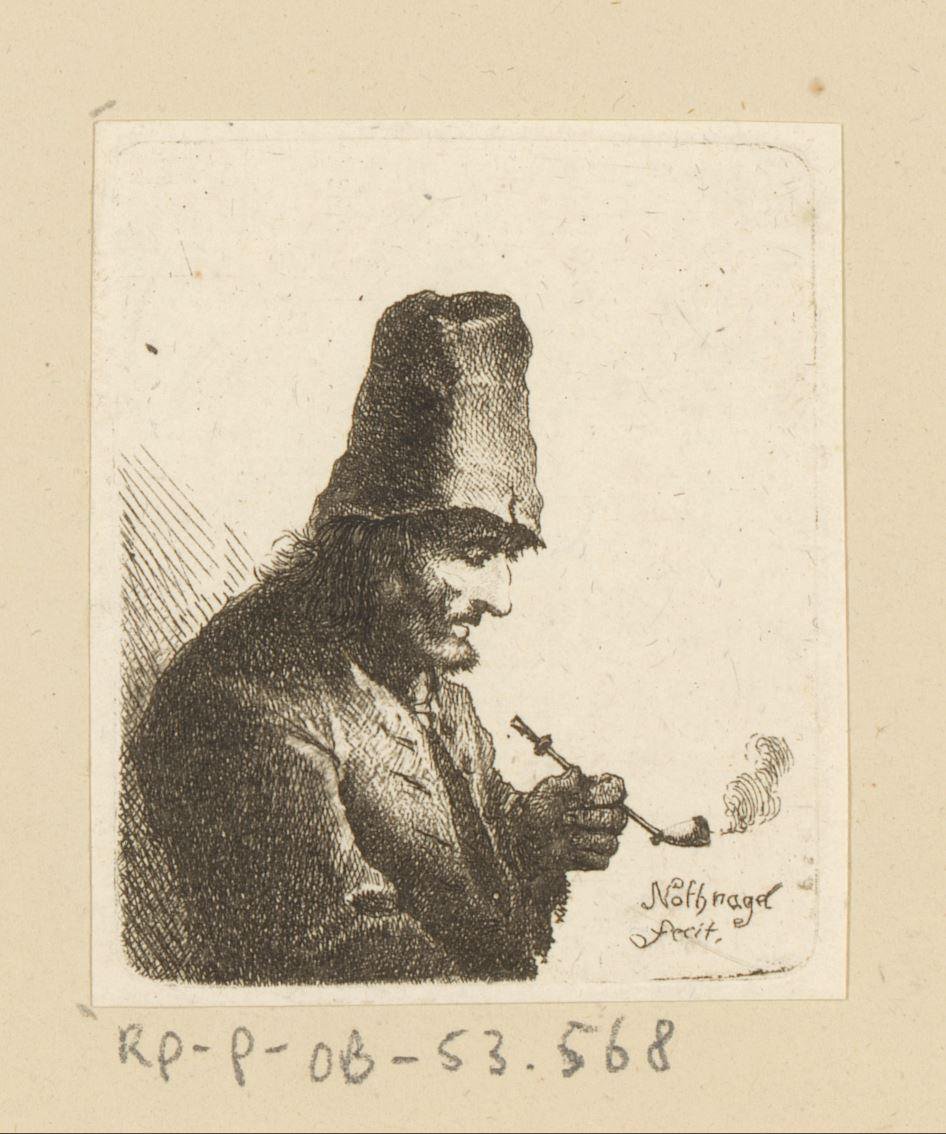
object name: print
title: Man met pijp en hoge muts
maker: johann andreas benjamin nothnagel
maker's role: print maker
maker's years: 1729-1804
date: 1739-1804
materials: paper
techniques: etching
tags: head-gear: cap (+ men's clothes), pipe ~ tobacco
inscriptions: collector's mark: Lugt 240